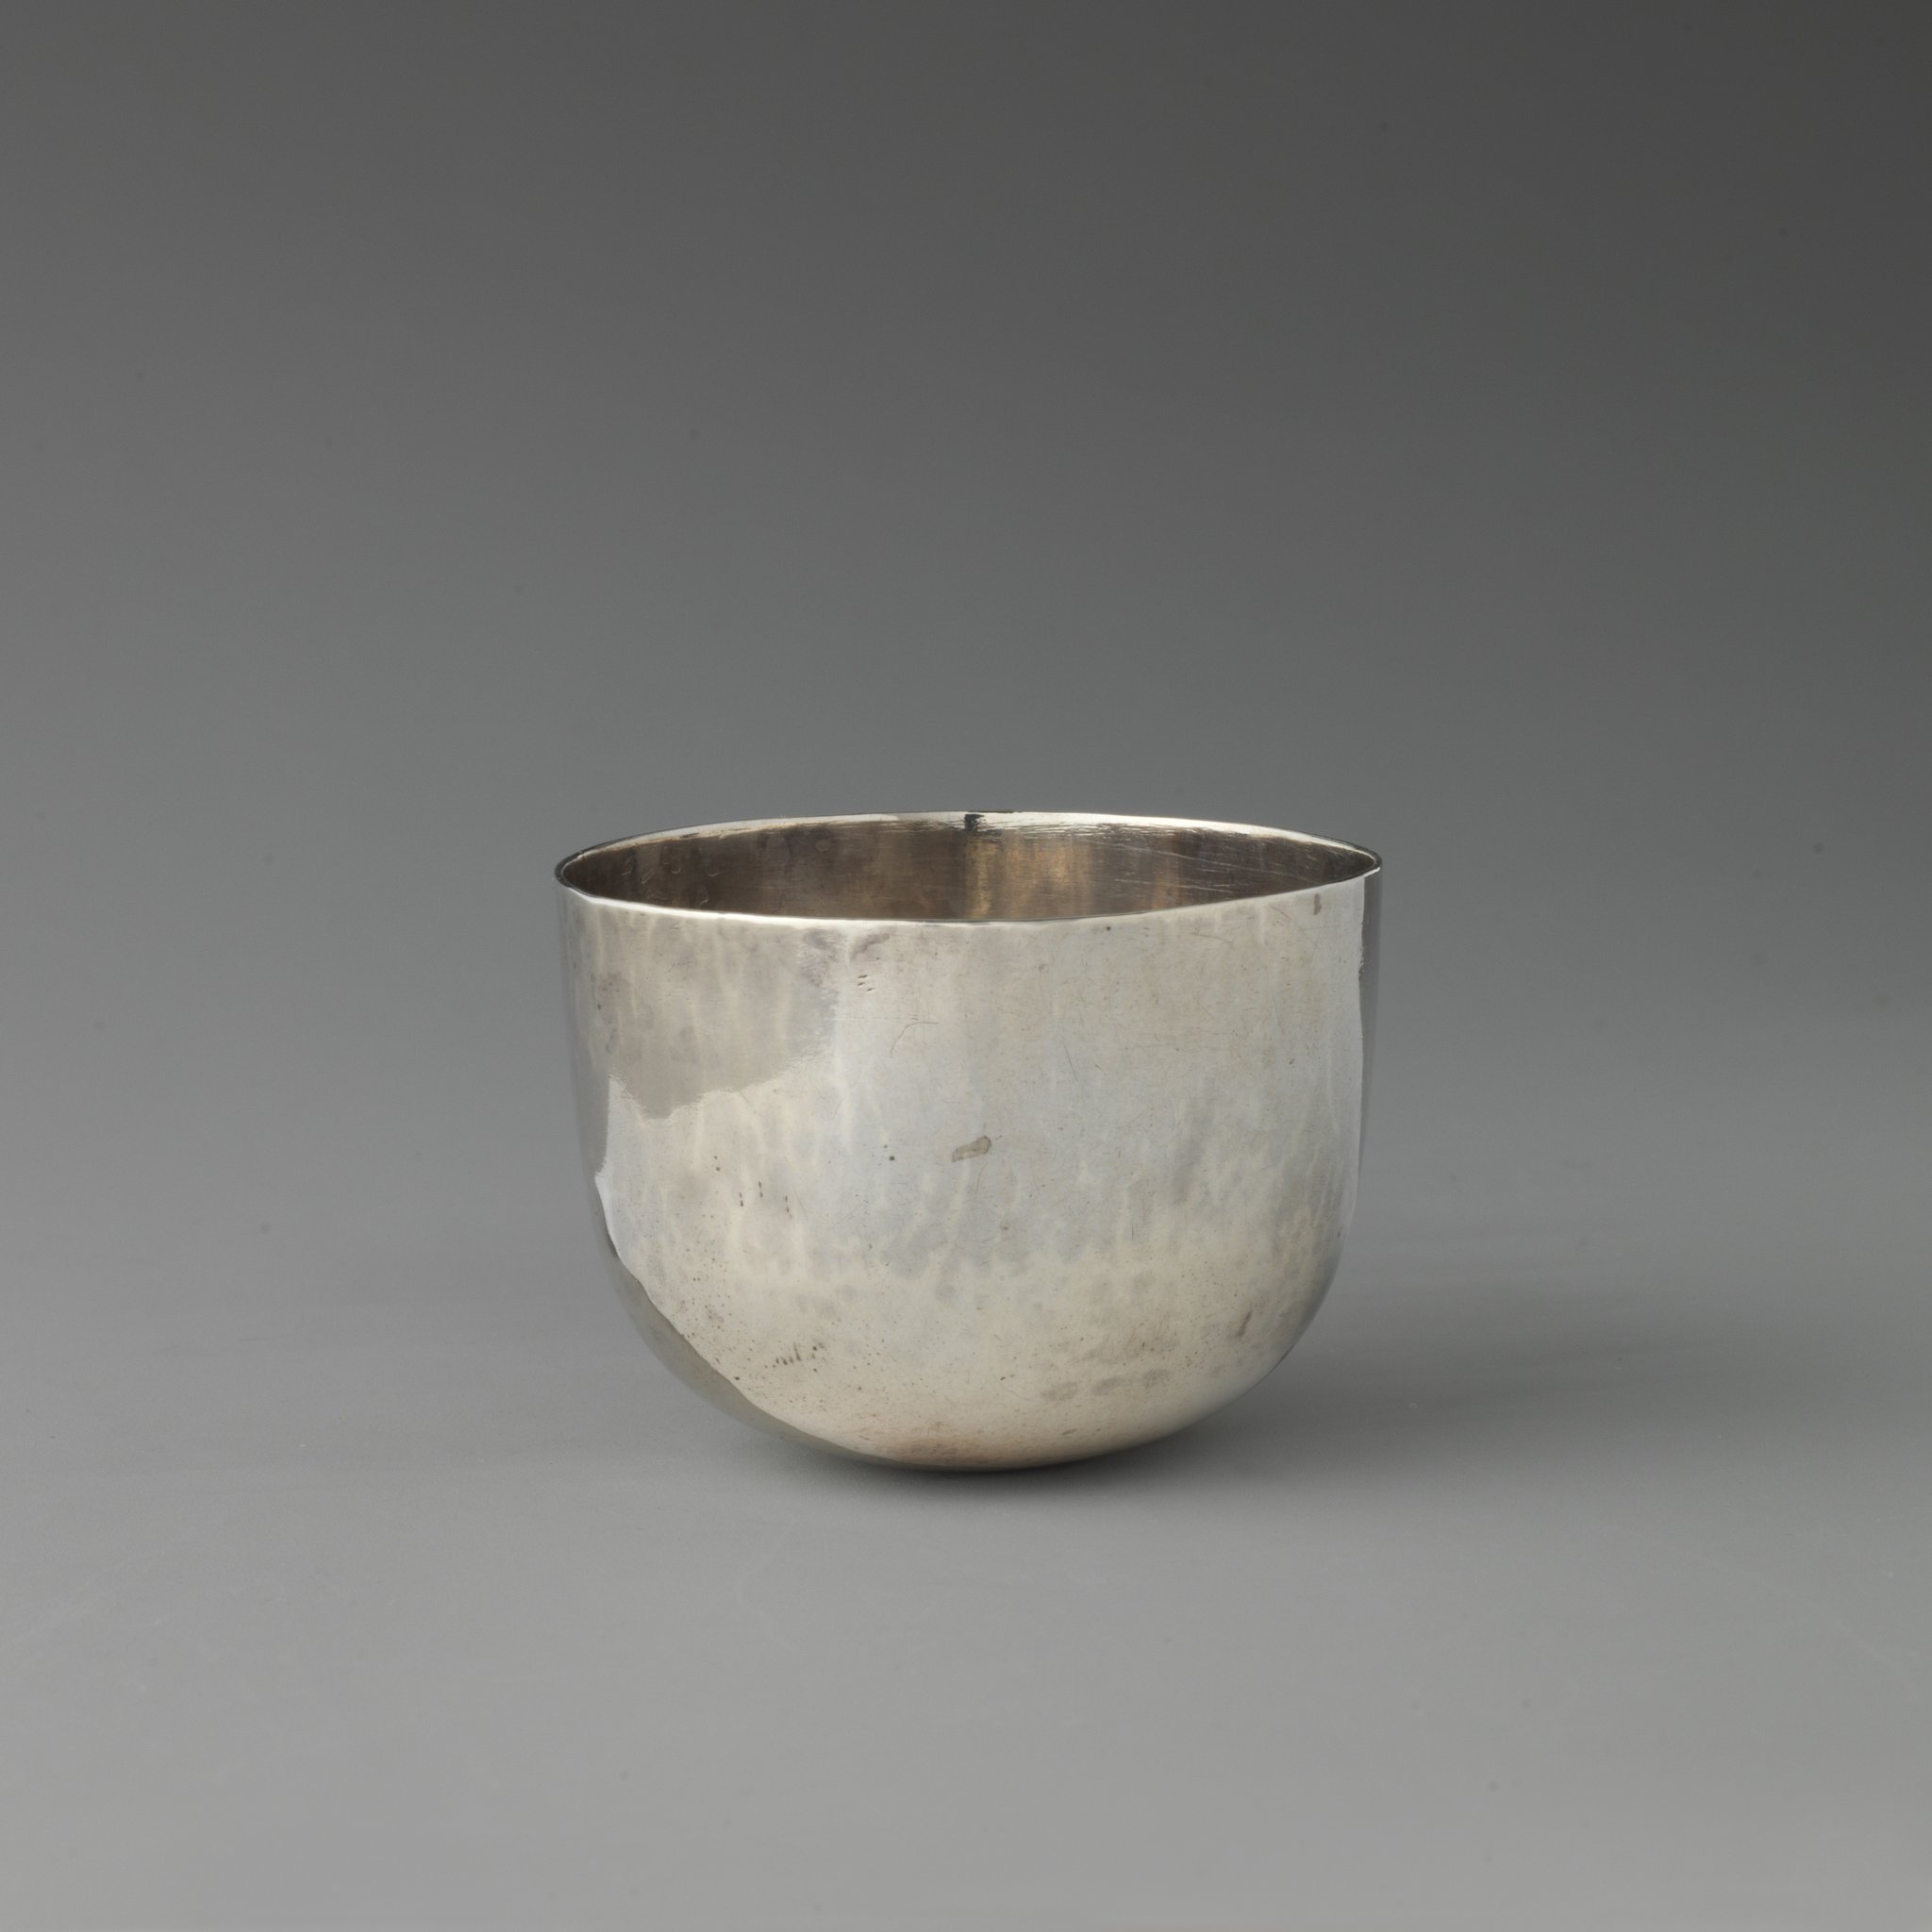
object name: tumbler cup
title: Miniature tumbler cup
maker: g. h.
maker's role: maker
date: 1688-1689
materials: silver